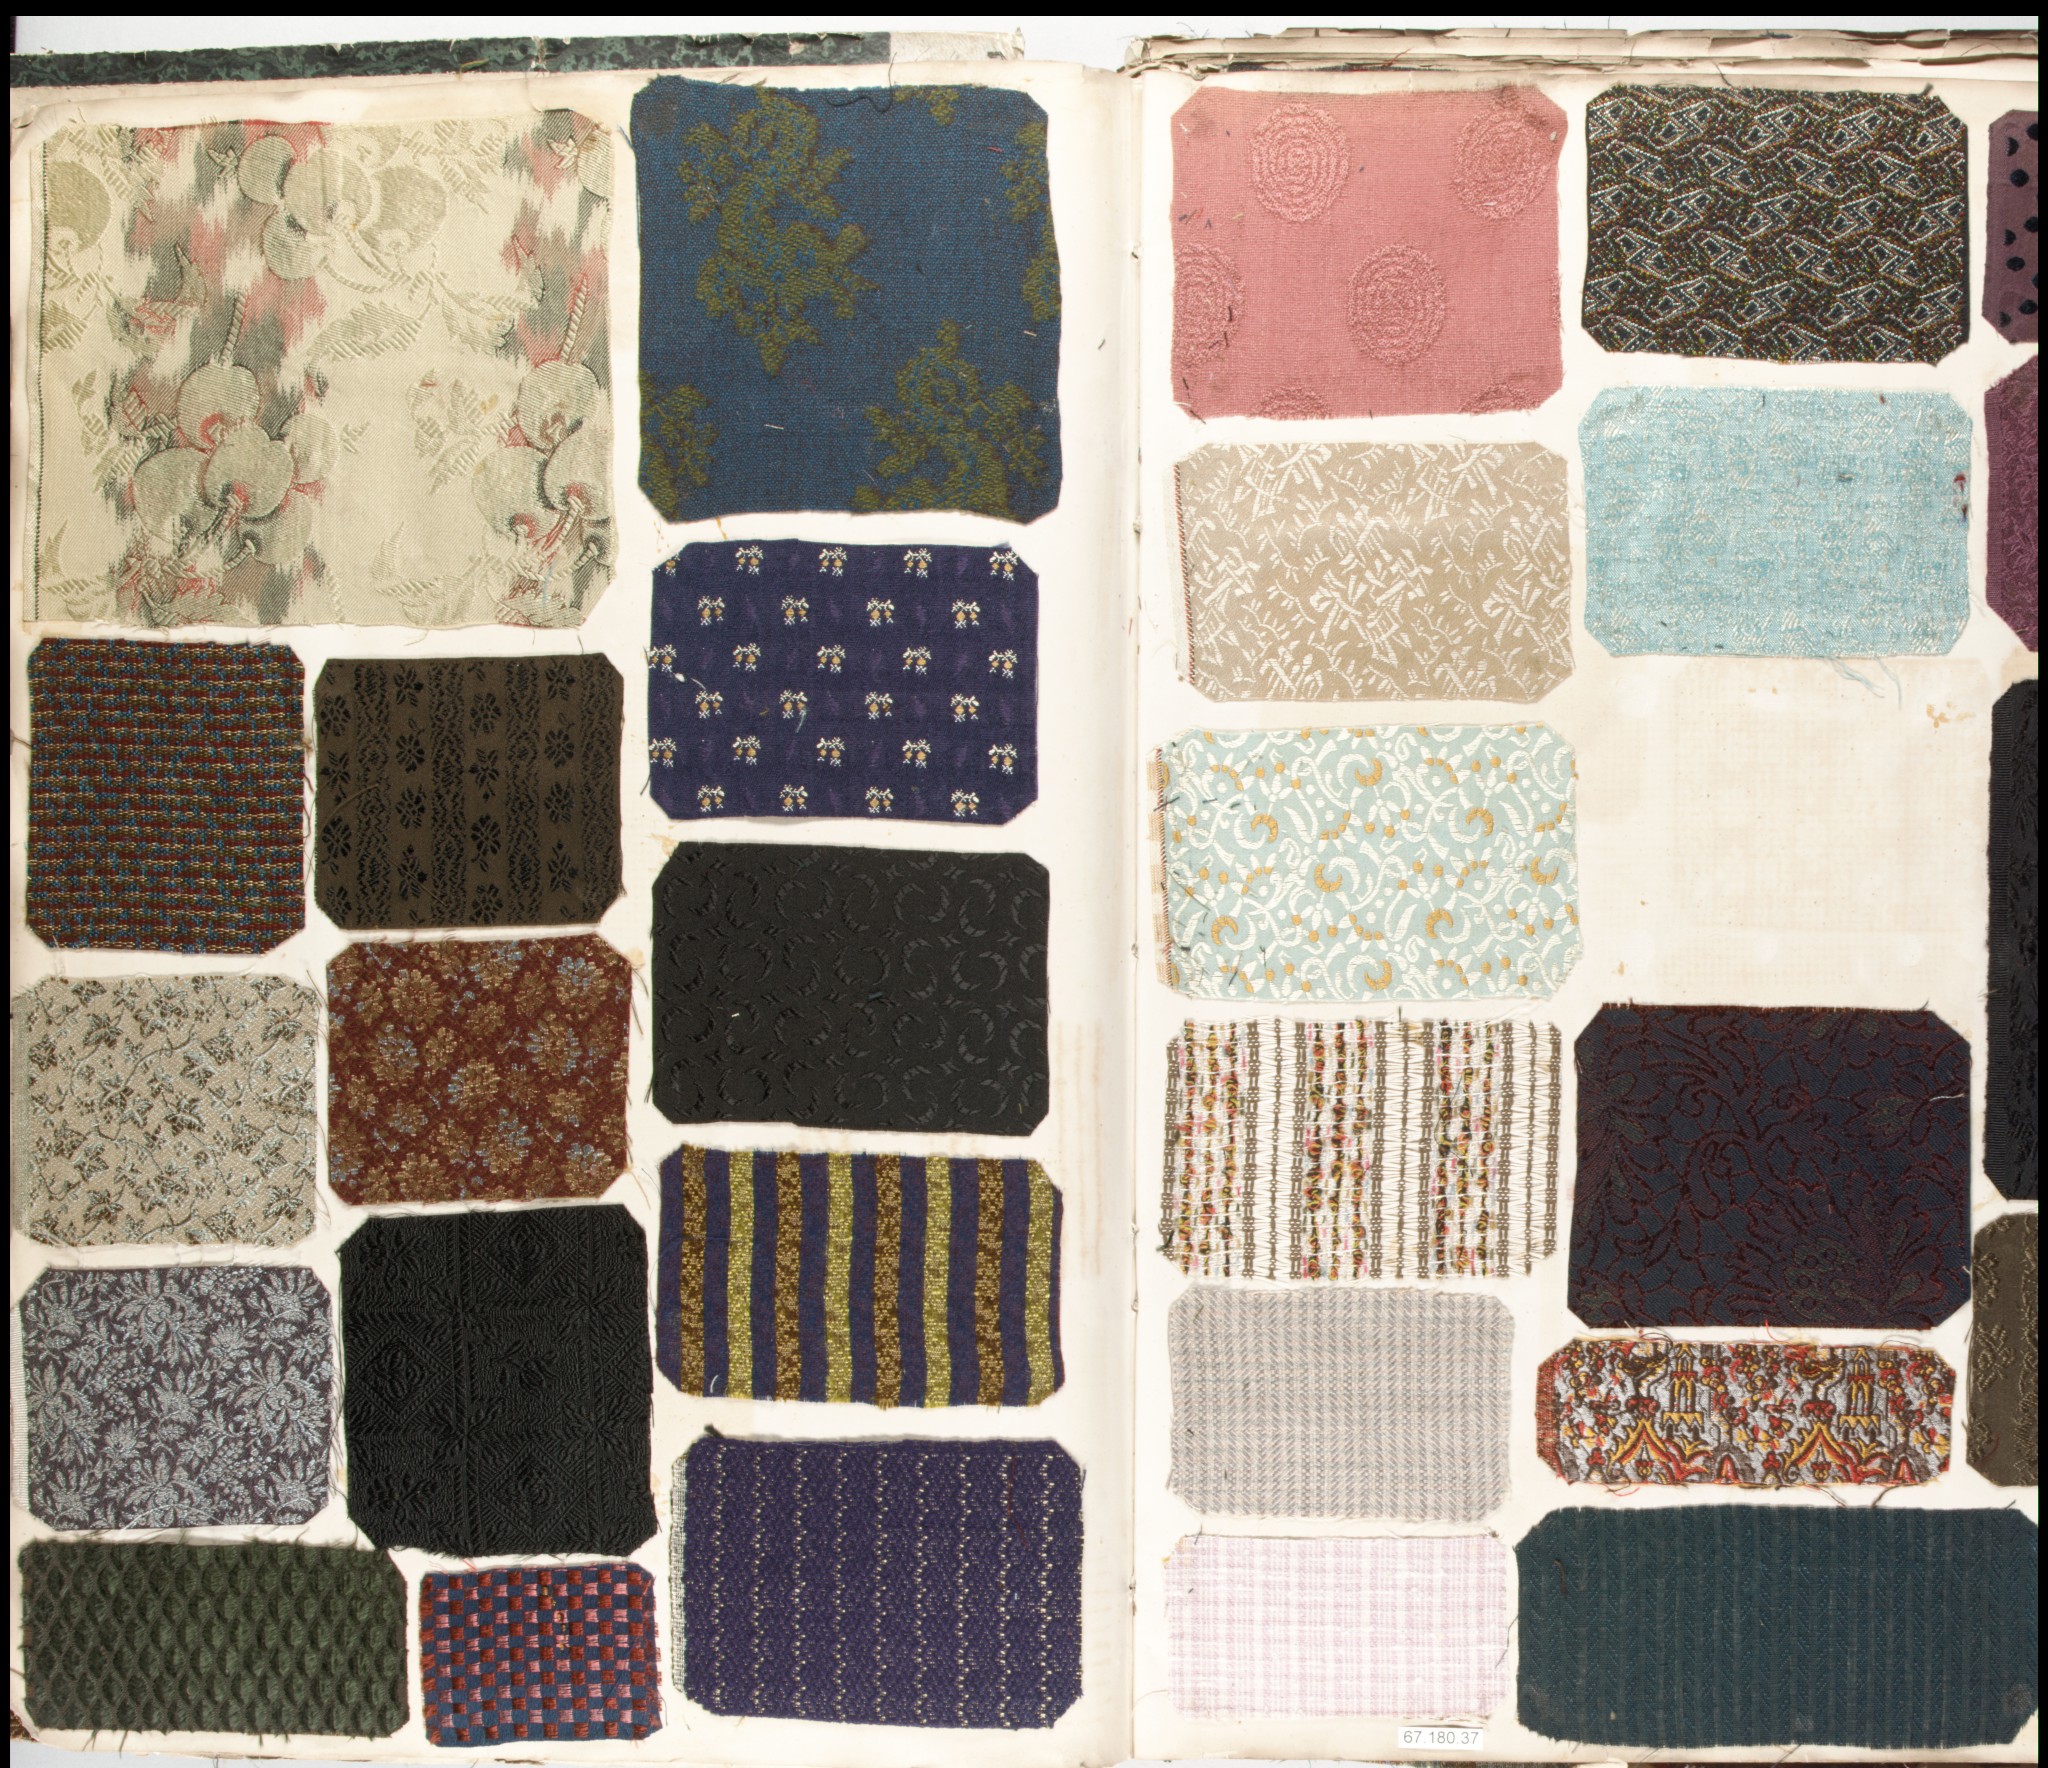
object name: sample book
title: Textile Sample Book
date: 1851-1900